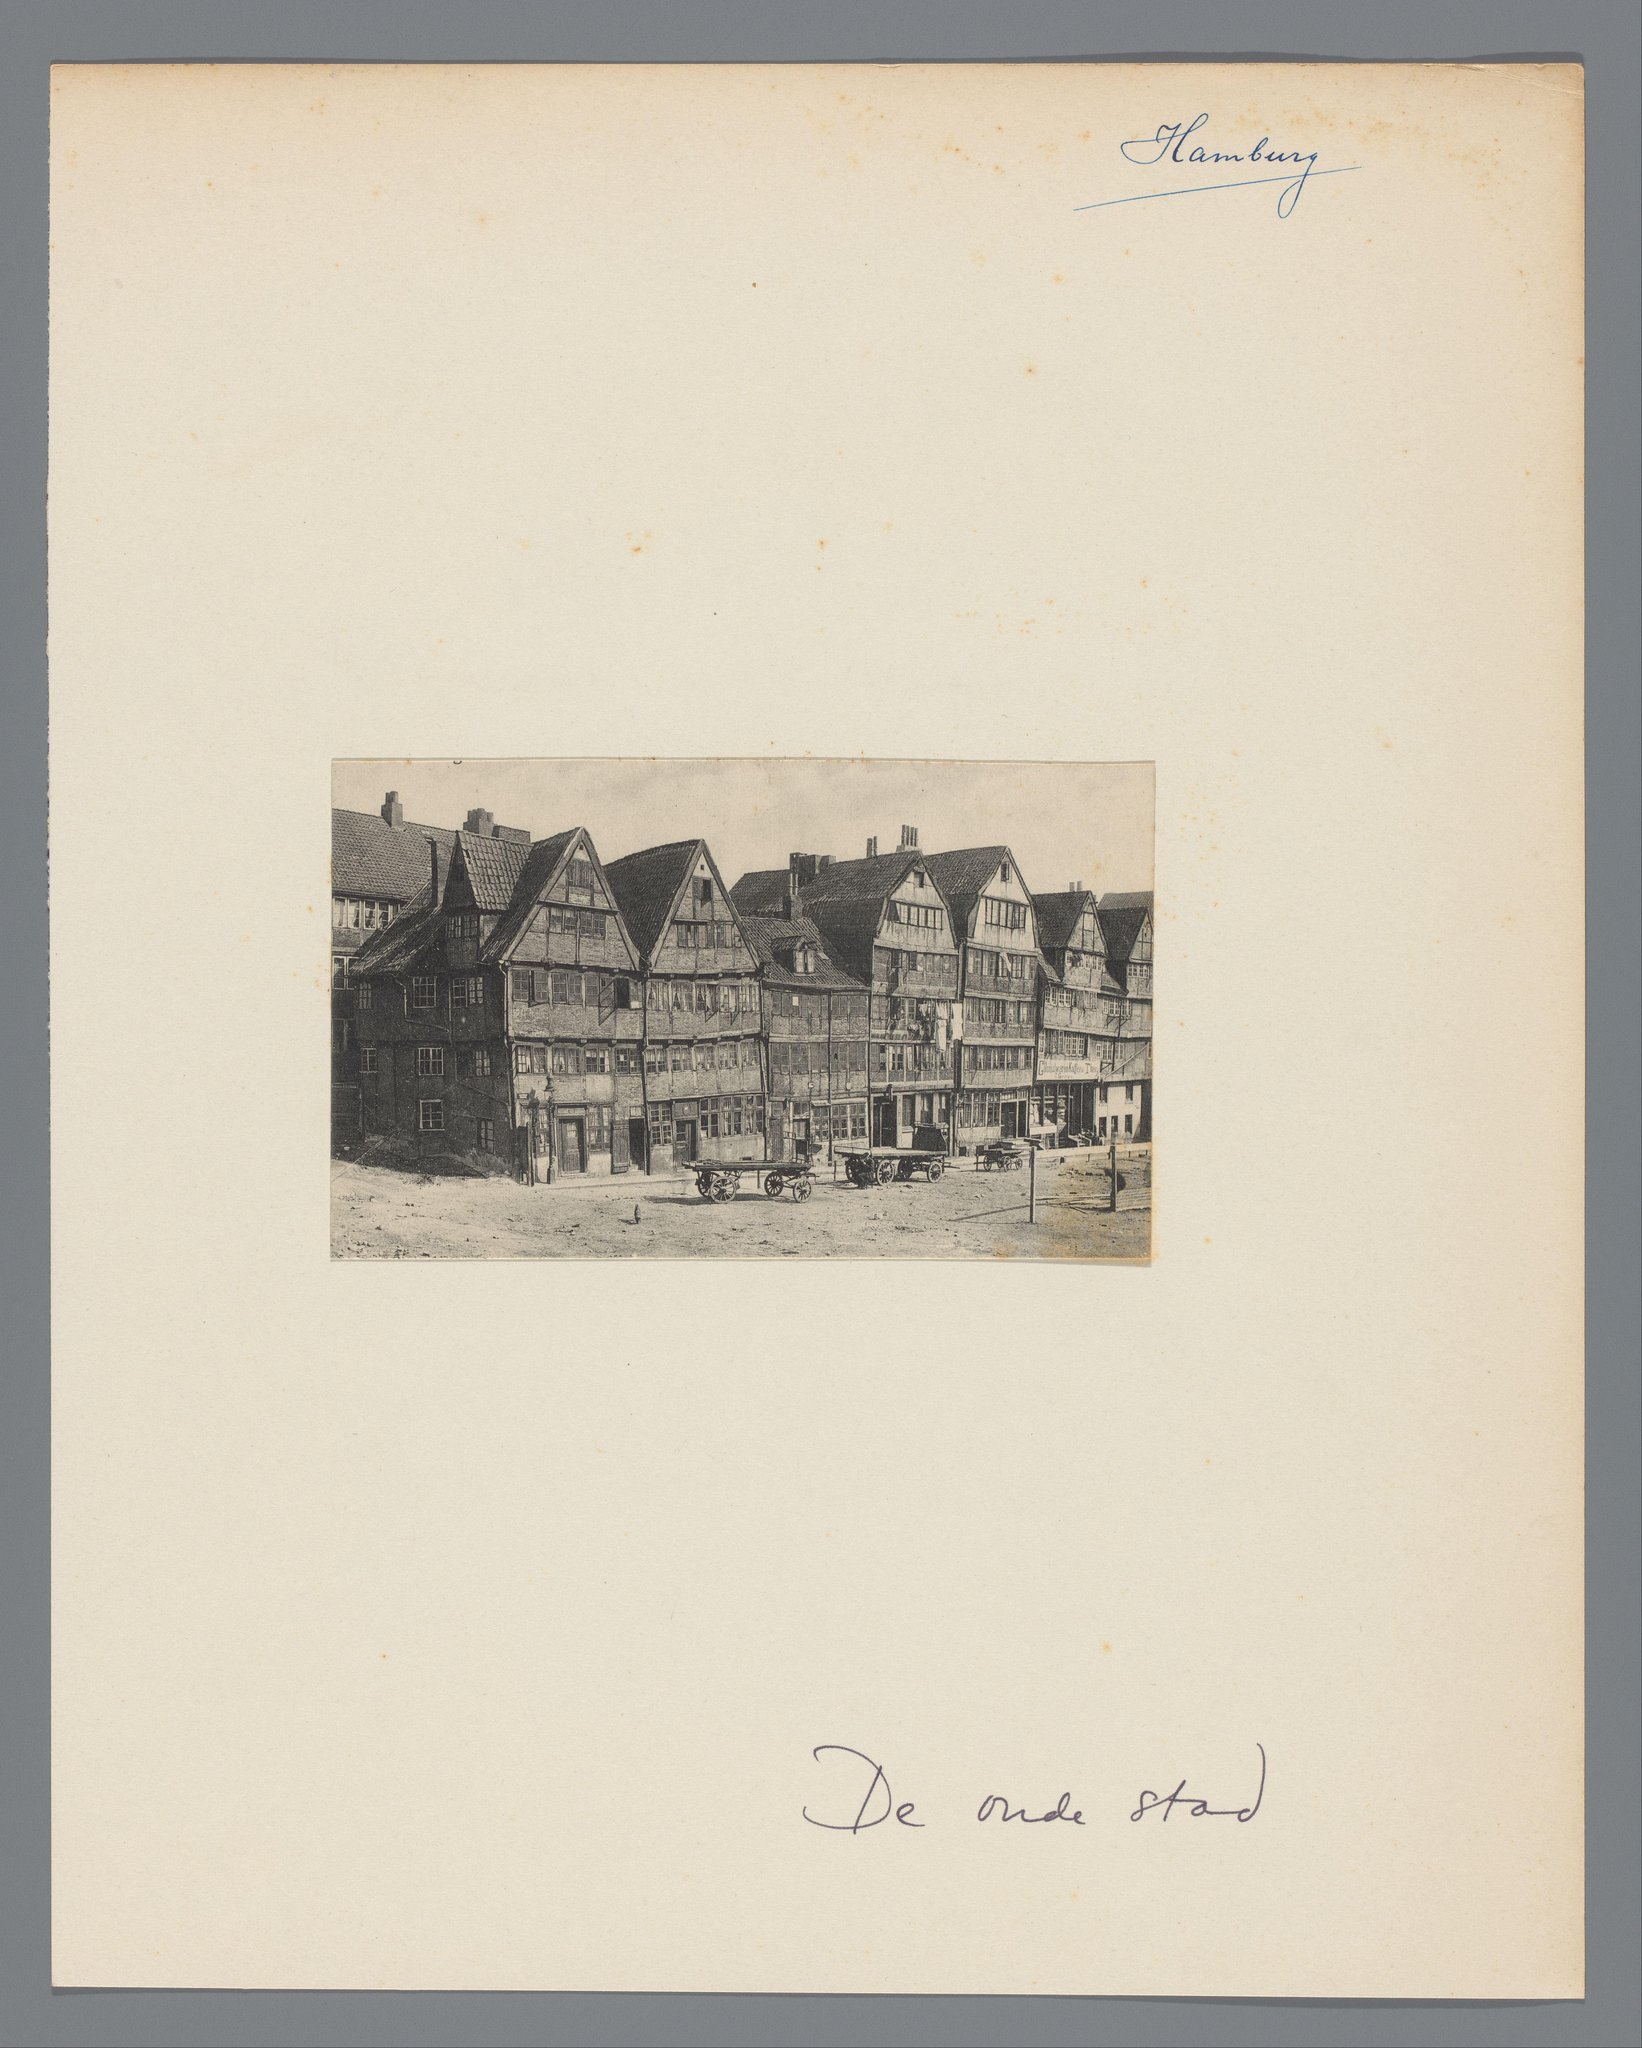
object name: photograph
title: Hamburg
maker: Anonymous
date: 1880-1920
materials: photographic support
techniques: photograph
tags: hamburg